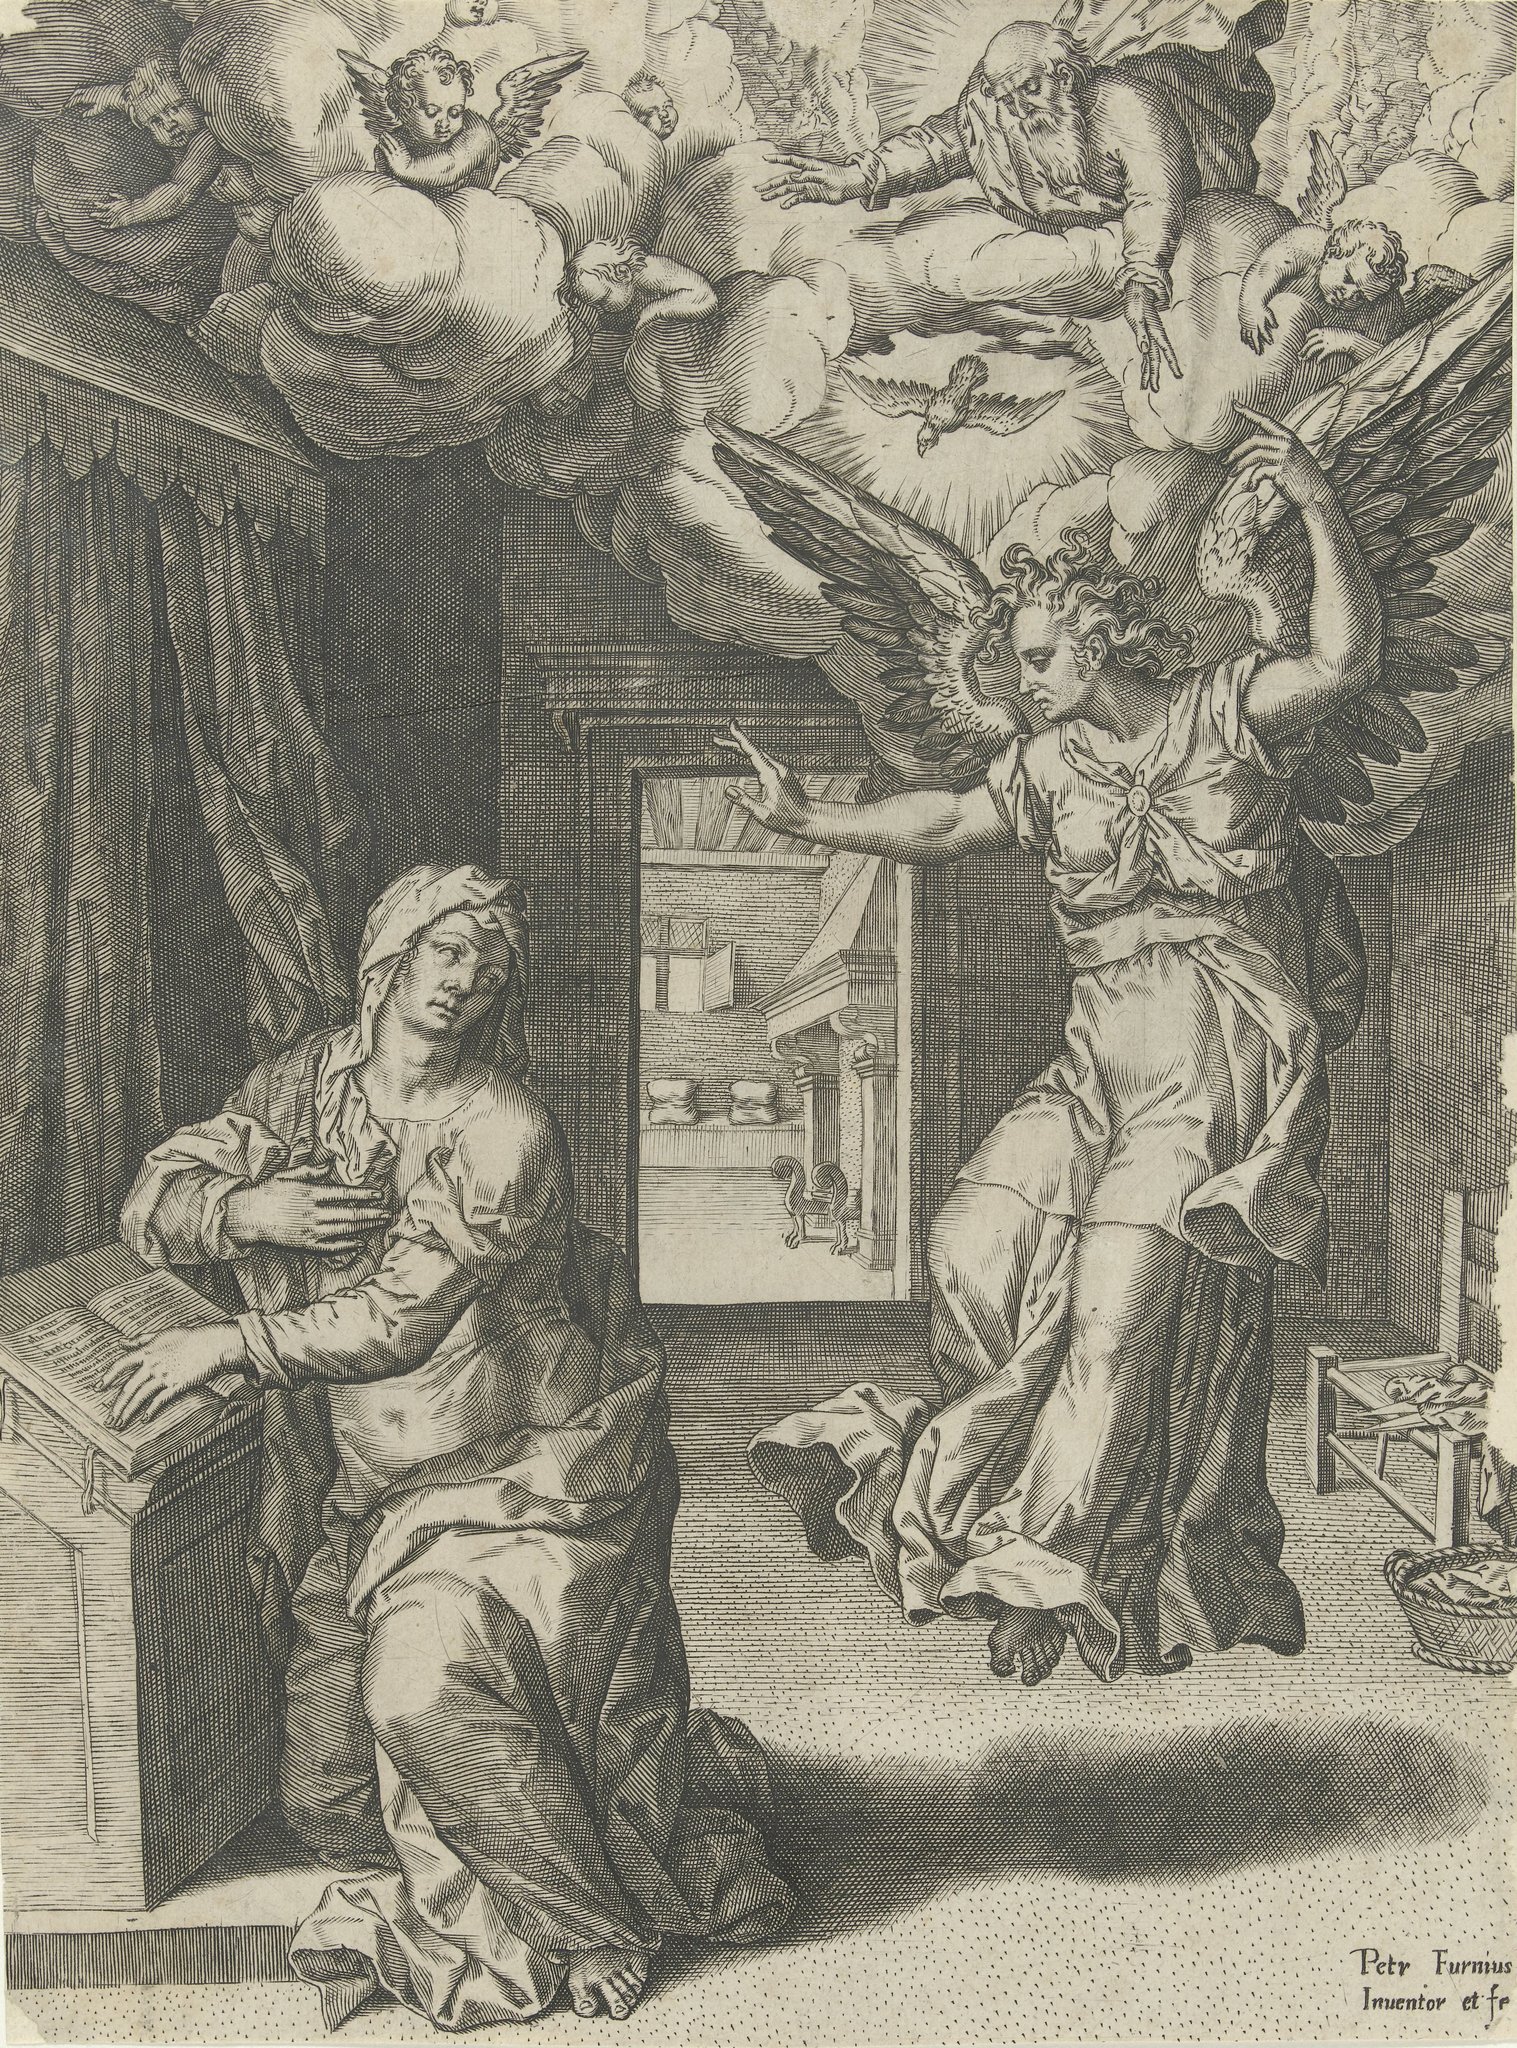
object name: print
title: Aankondiging van de geboorte van Christus aan Maria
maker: pieter jalhea furnius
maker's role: print maker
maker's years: 1540-1626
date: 1550-1625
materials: paper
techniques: engraving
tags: the annunciation: mary kneeling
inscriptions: collector's mark: Lugt 2228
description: De engel Gabriël verschijnt aan Maria terwijl zij zit te lezen aan een lezenaar in een vertrek. Boven de engel zijn God en de Heilige Geest in de gedaante van een duif en in het bijzijn van engelen eveneens verschenen. Onder de voorstelling staat een regel tekst in het Latijn.